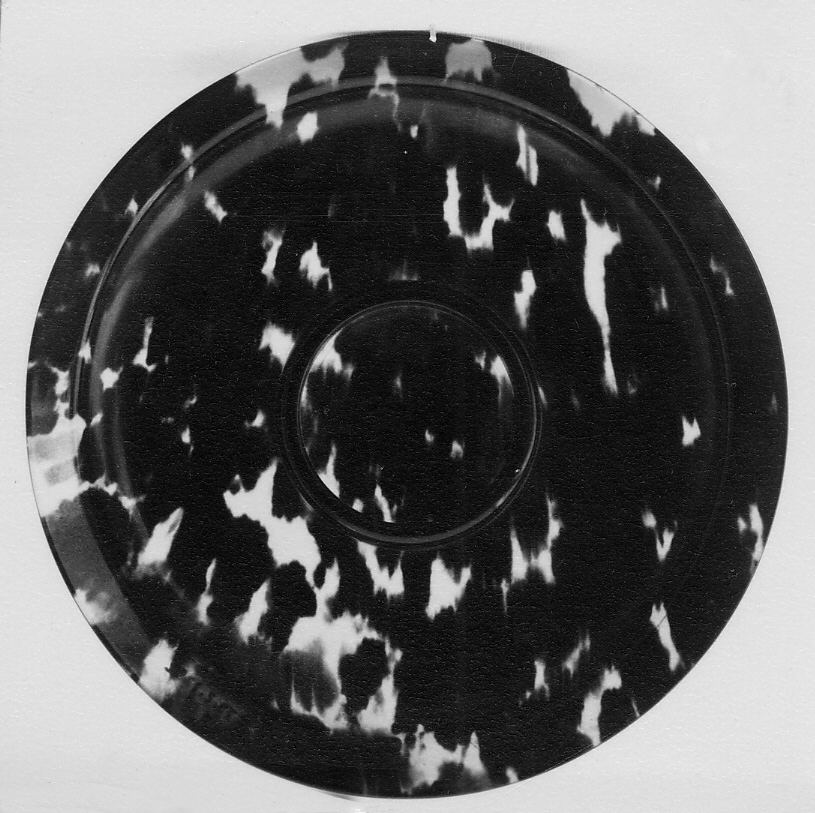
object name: saucer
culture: chinese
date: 1801-1900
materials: shell